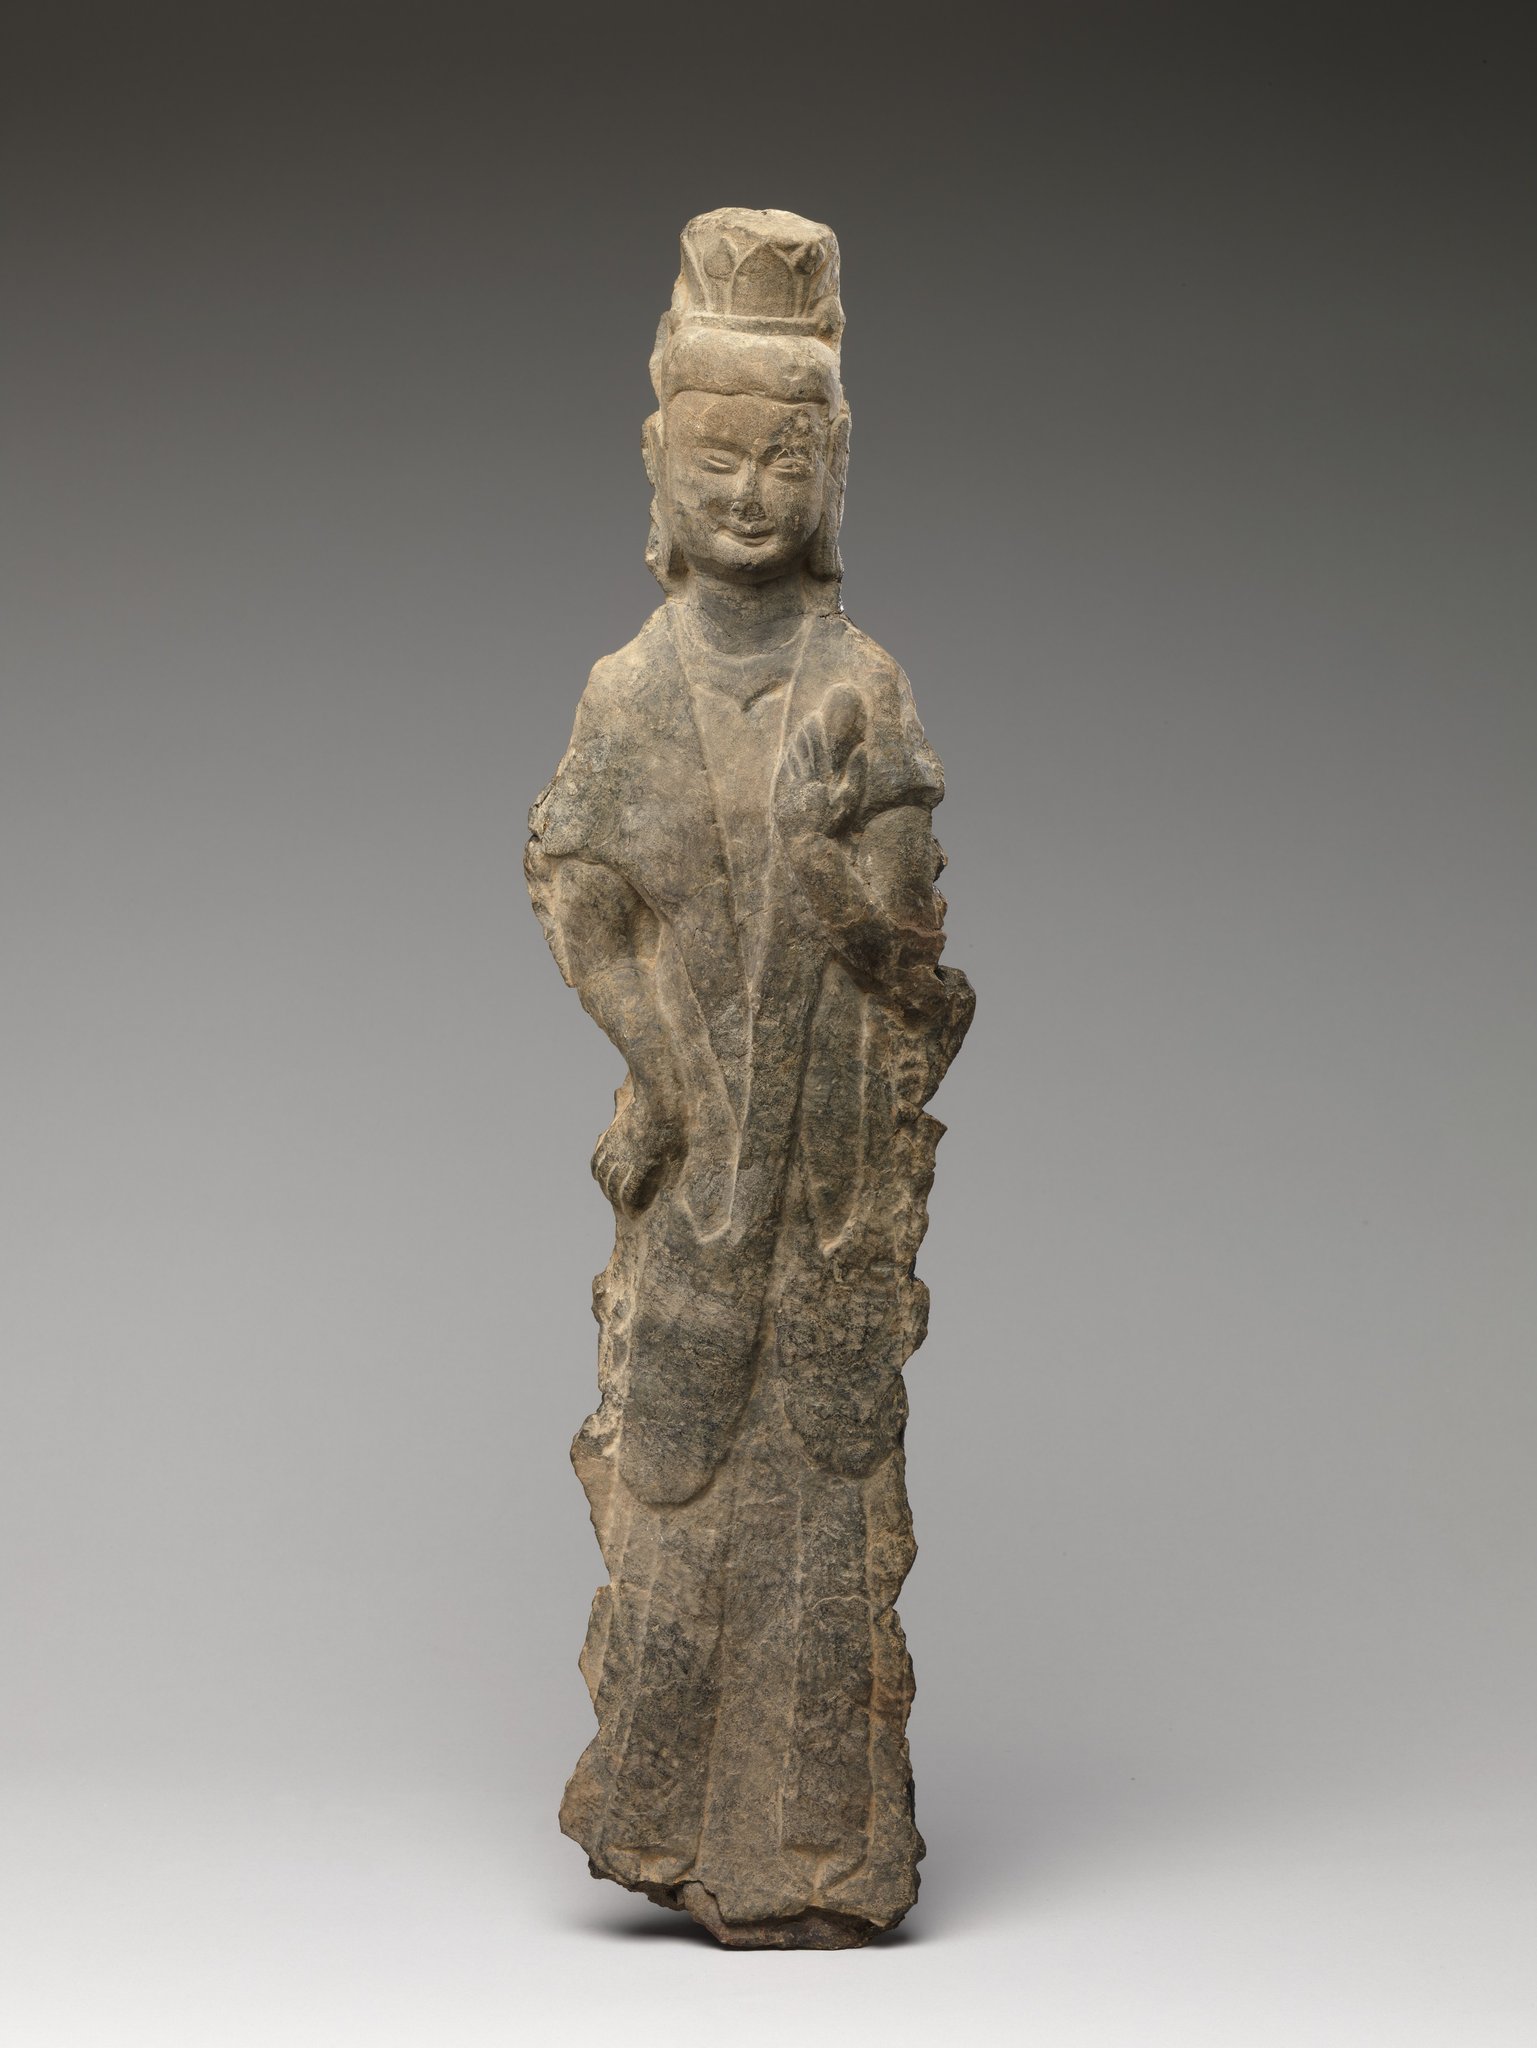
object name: figure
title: Attendant bodhisattva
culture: chinese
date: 501-533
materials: limestone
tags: human figures